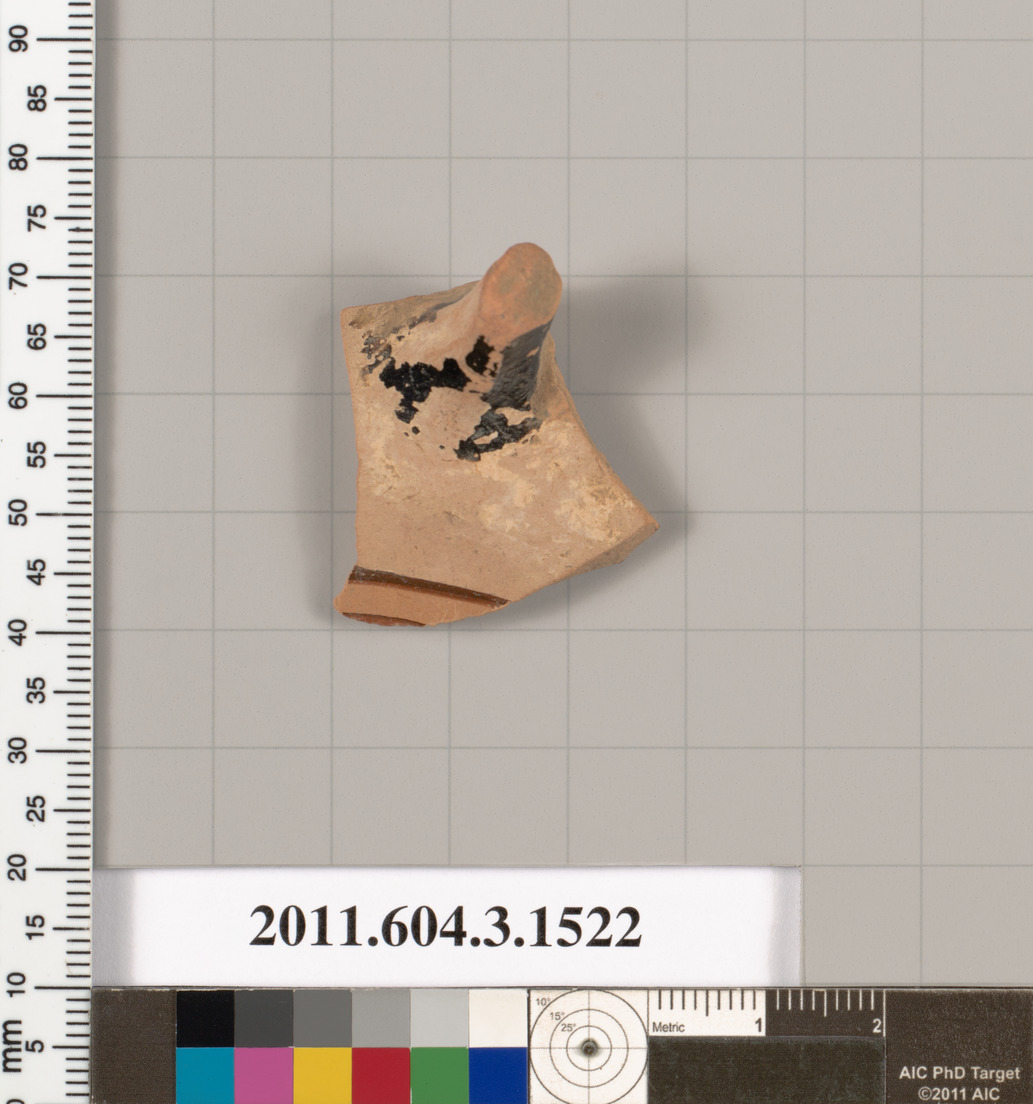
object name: skyphos fragment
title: Terracotta fragment of a skyphos (deep drinking cup)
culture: greek, attic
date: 534-468 BCE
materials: terracotta